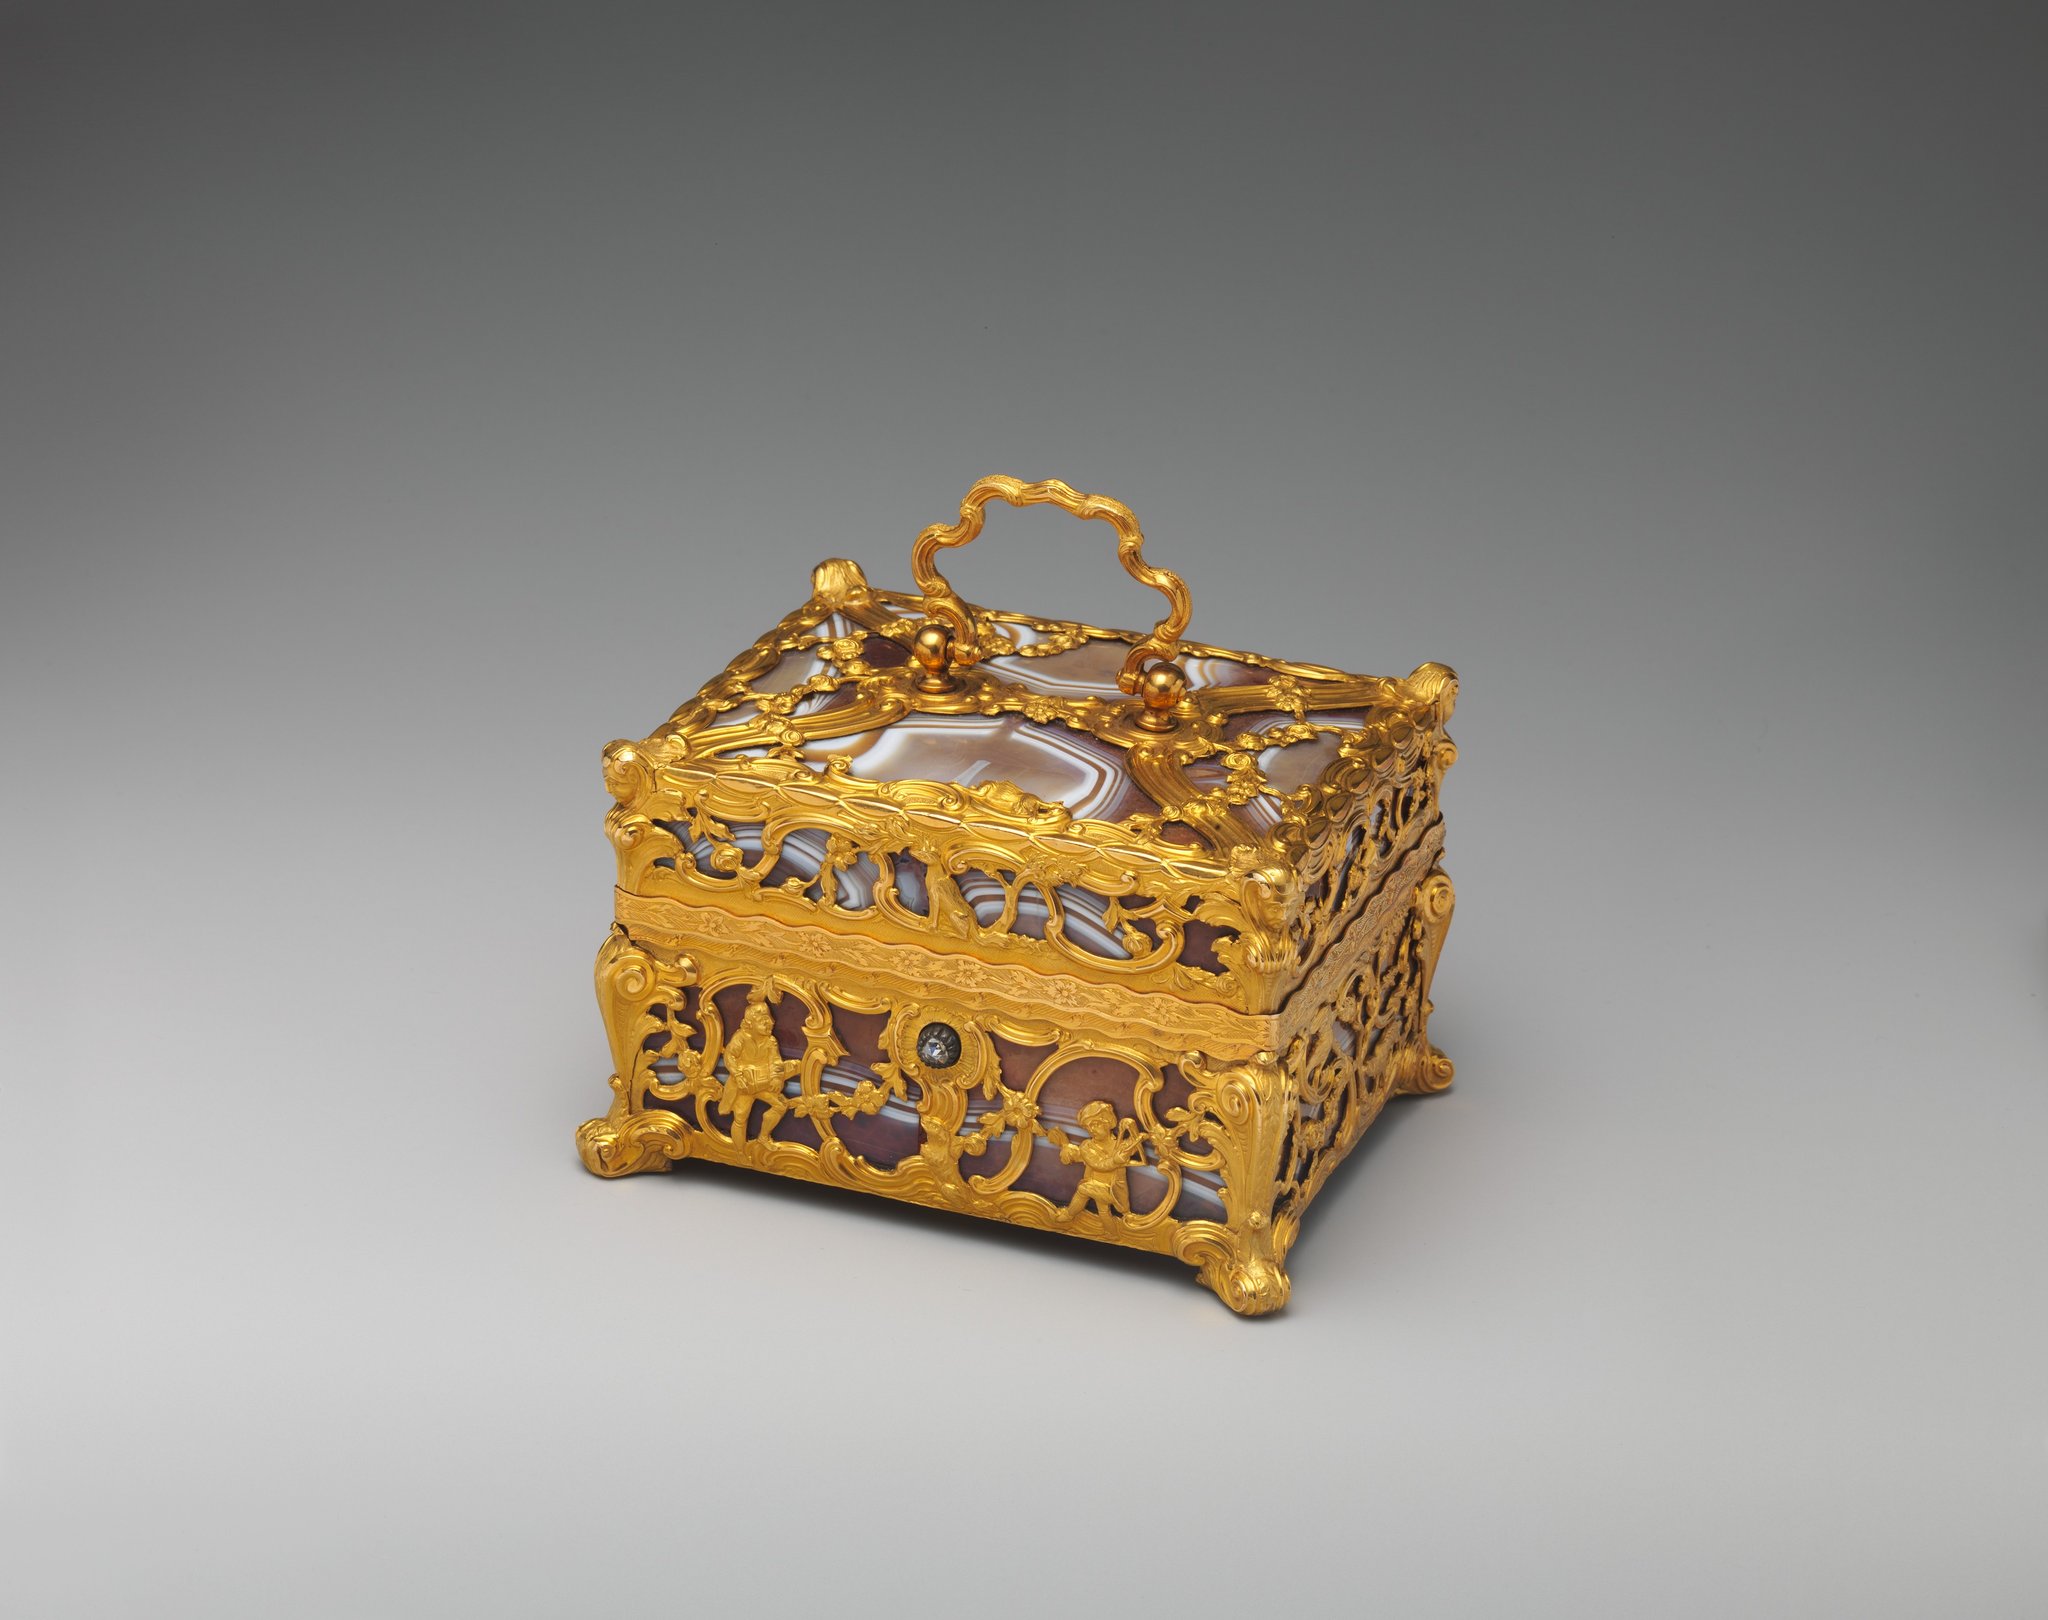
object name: jewel casket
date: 1734-1766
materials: stone, diamond, glass, gold